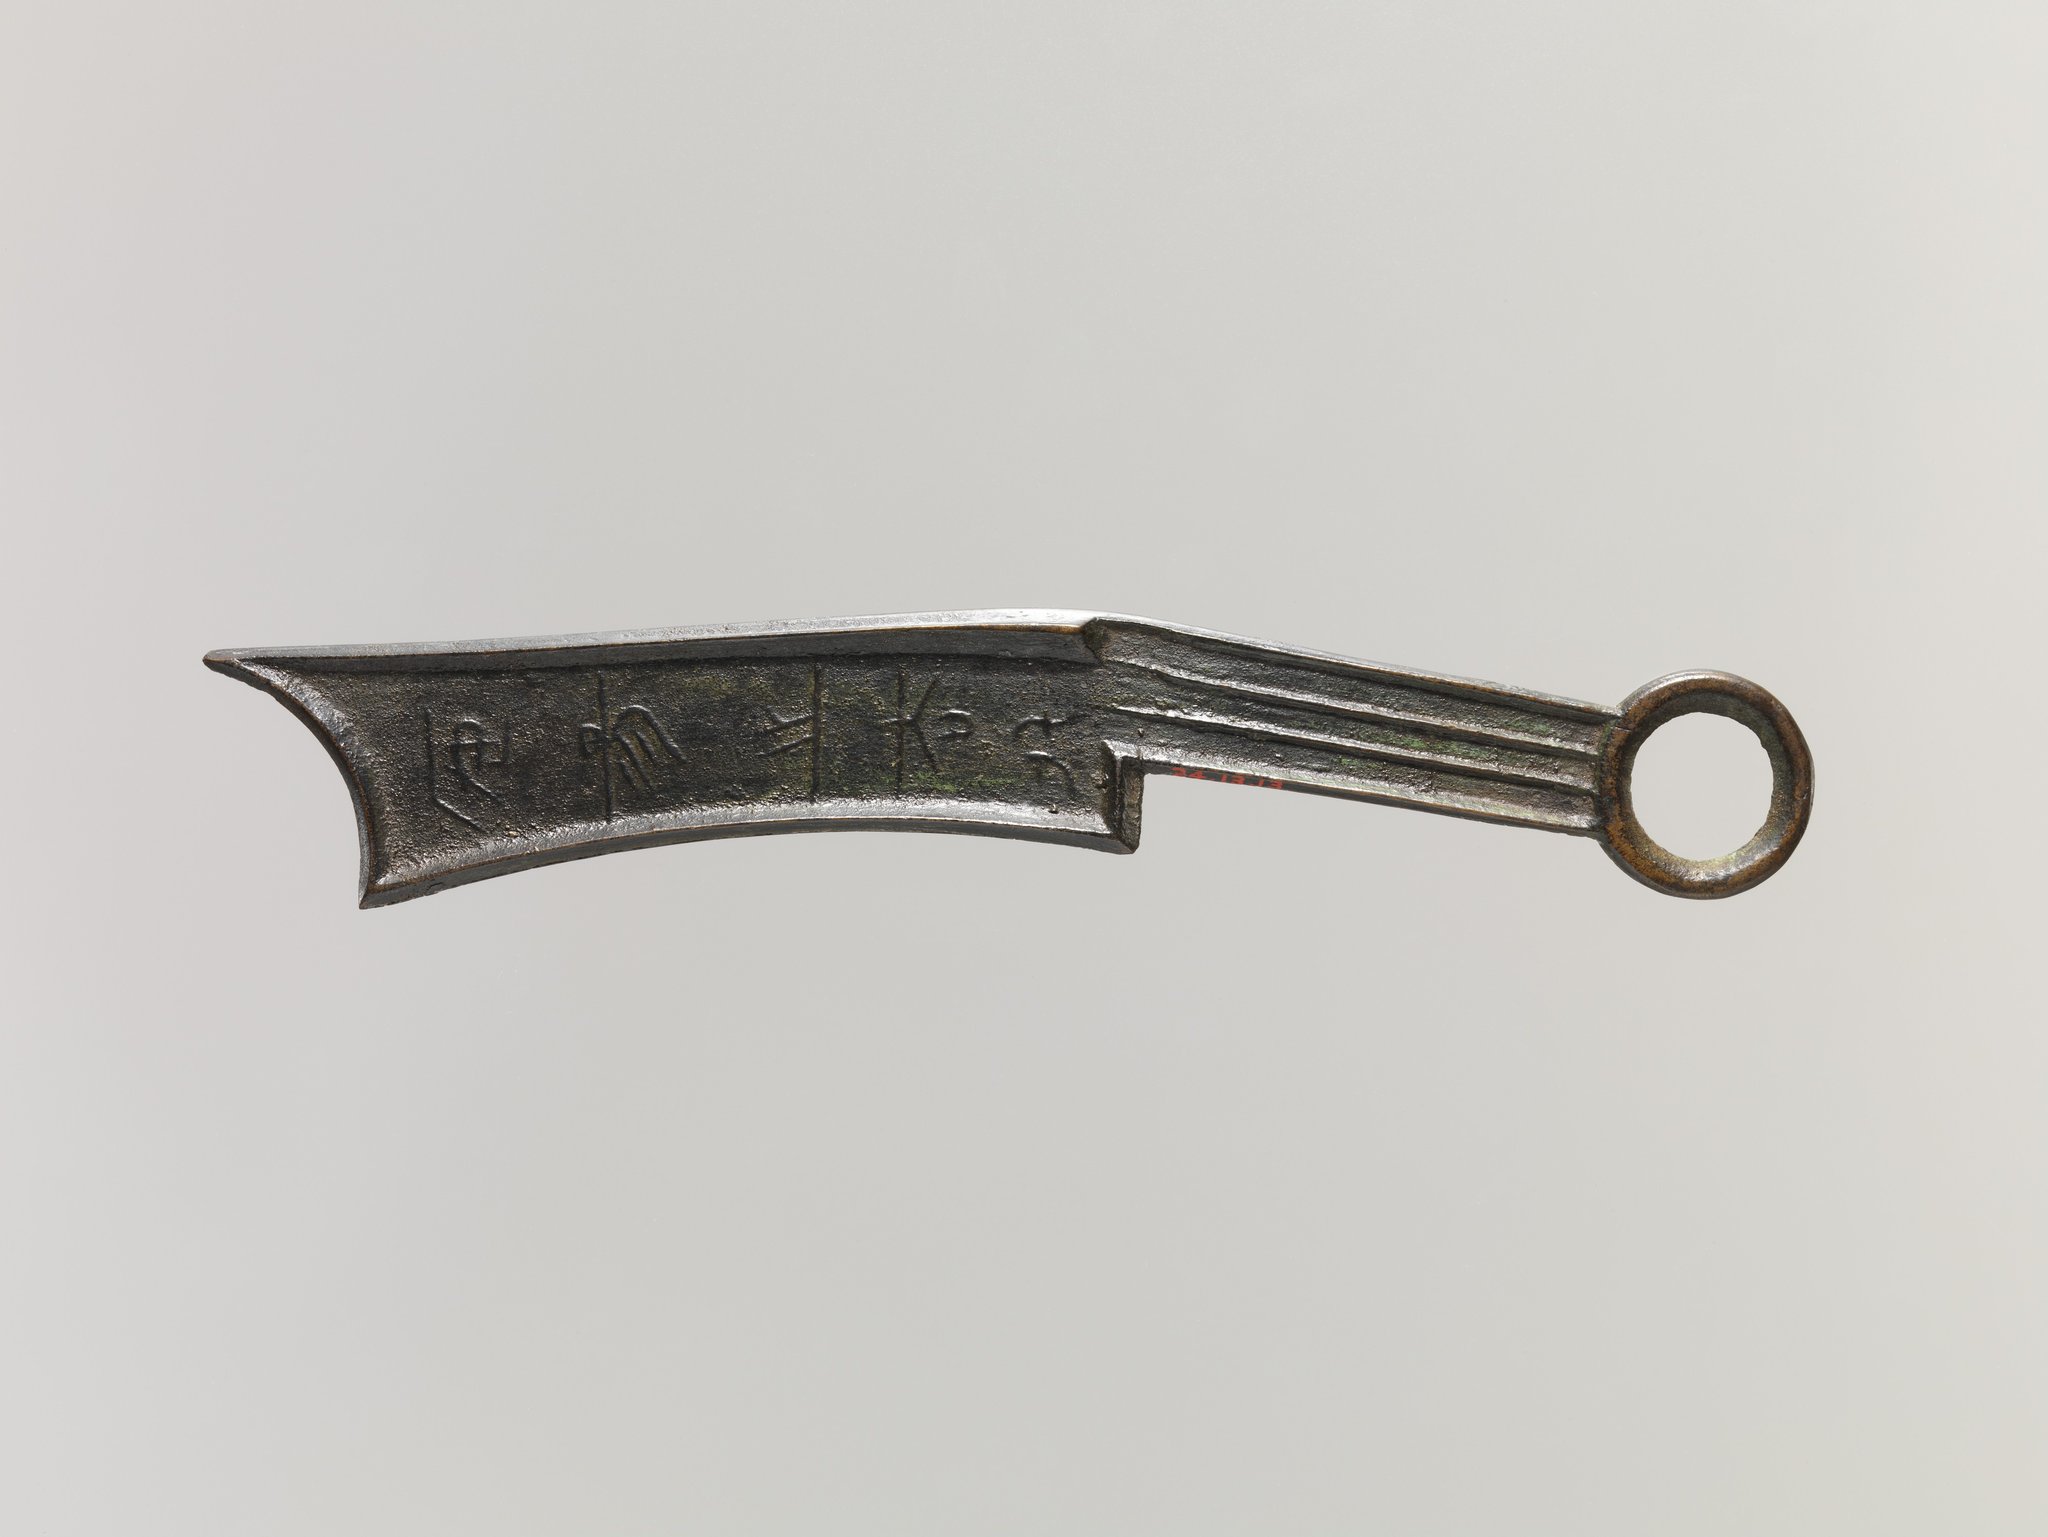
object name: knife coin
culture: chinese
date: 206 BCE-220 CE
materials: bronze